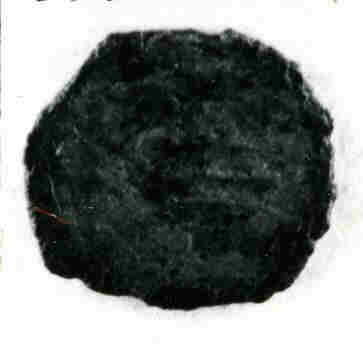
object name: coin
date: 790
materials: copper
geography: iran